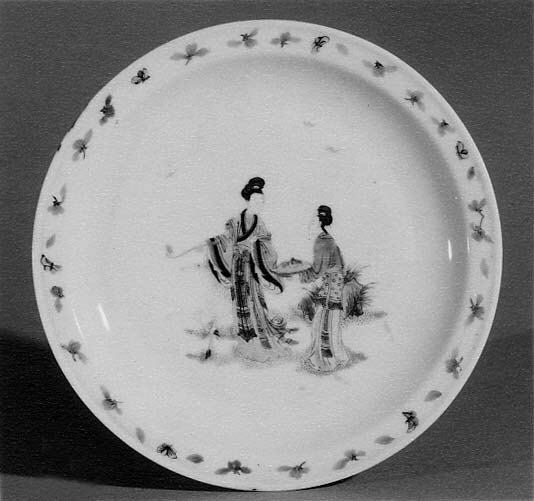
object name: plate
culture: chinese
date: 1700-1722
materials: enamel, porcelain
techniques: overglaze, painting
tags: women